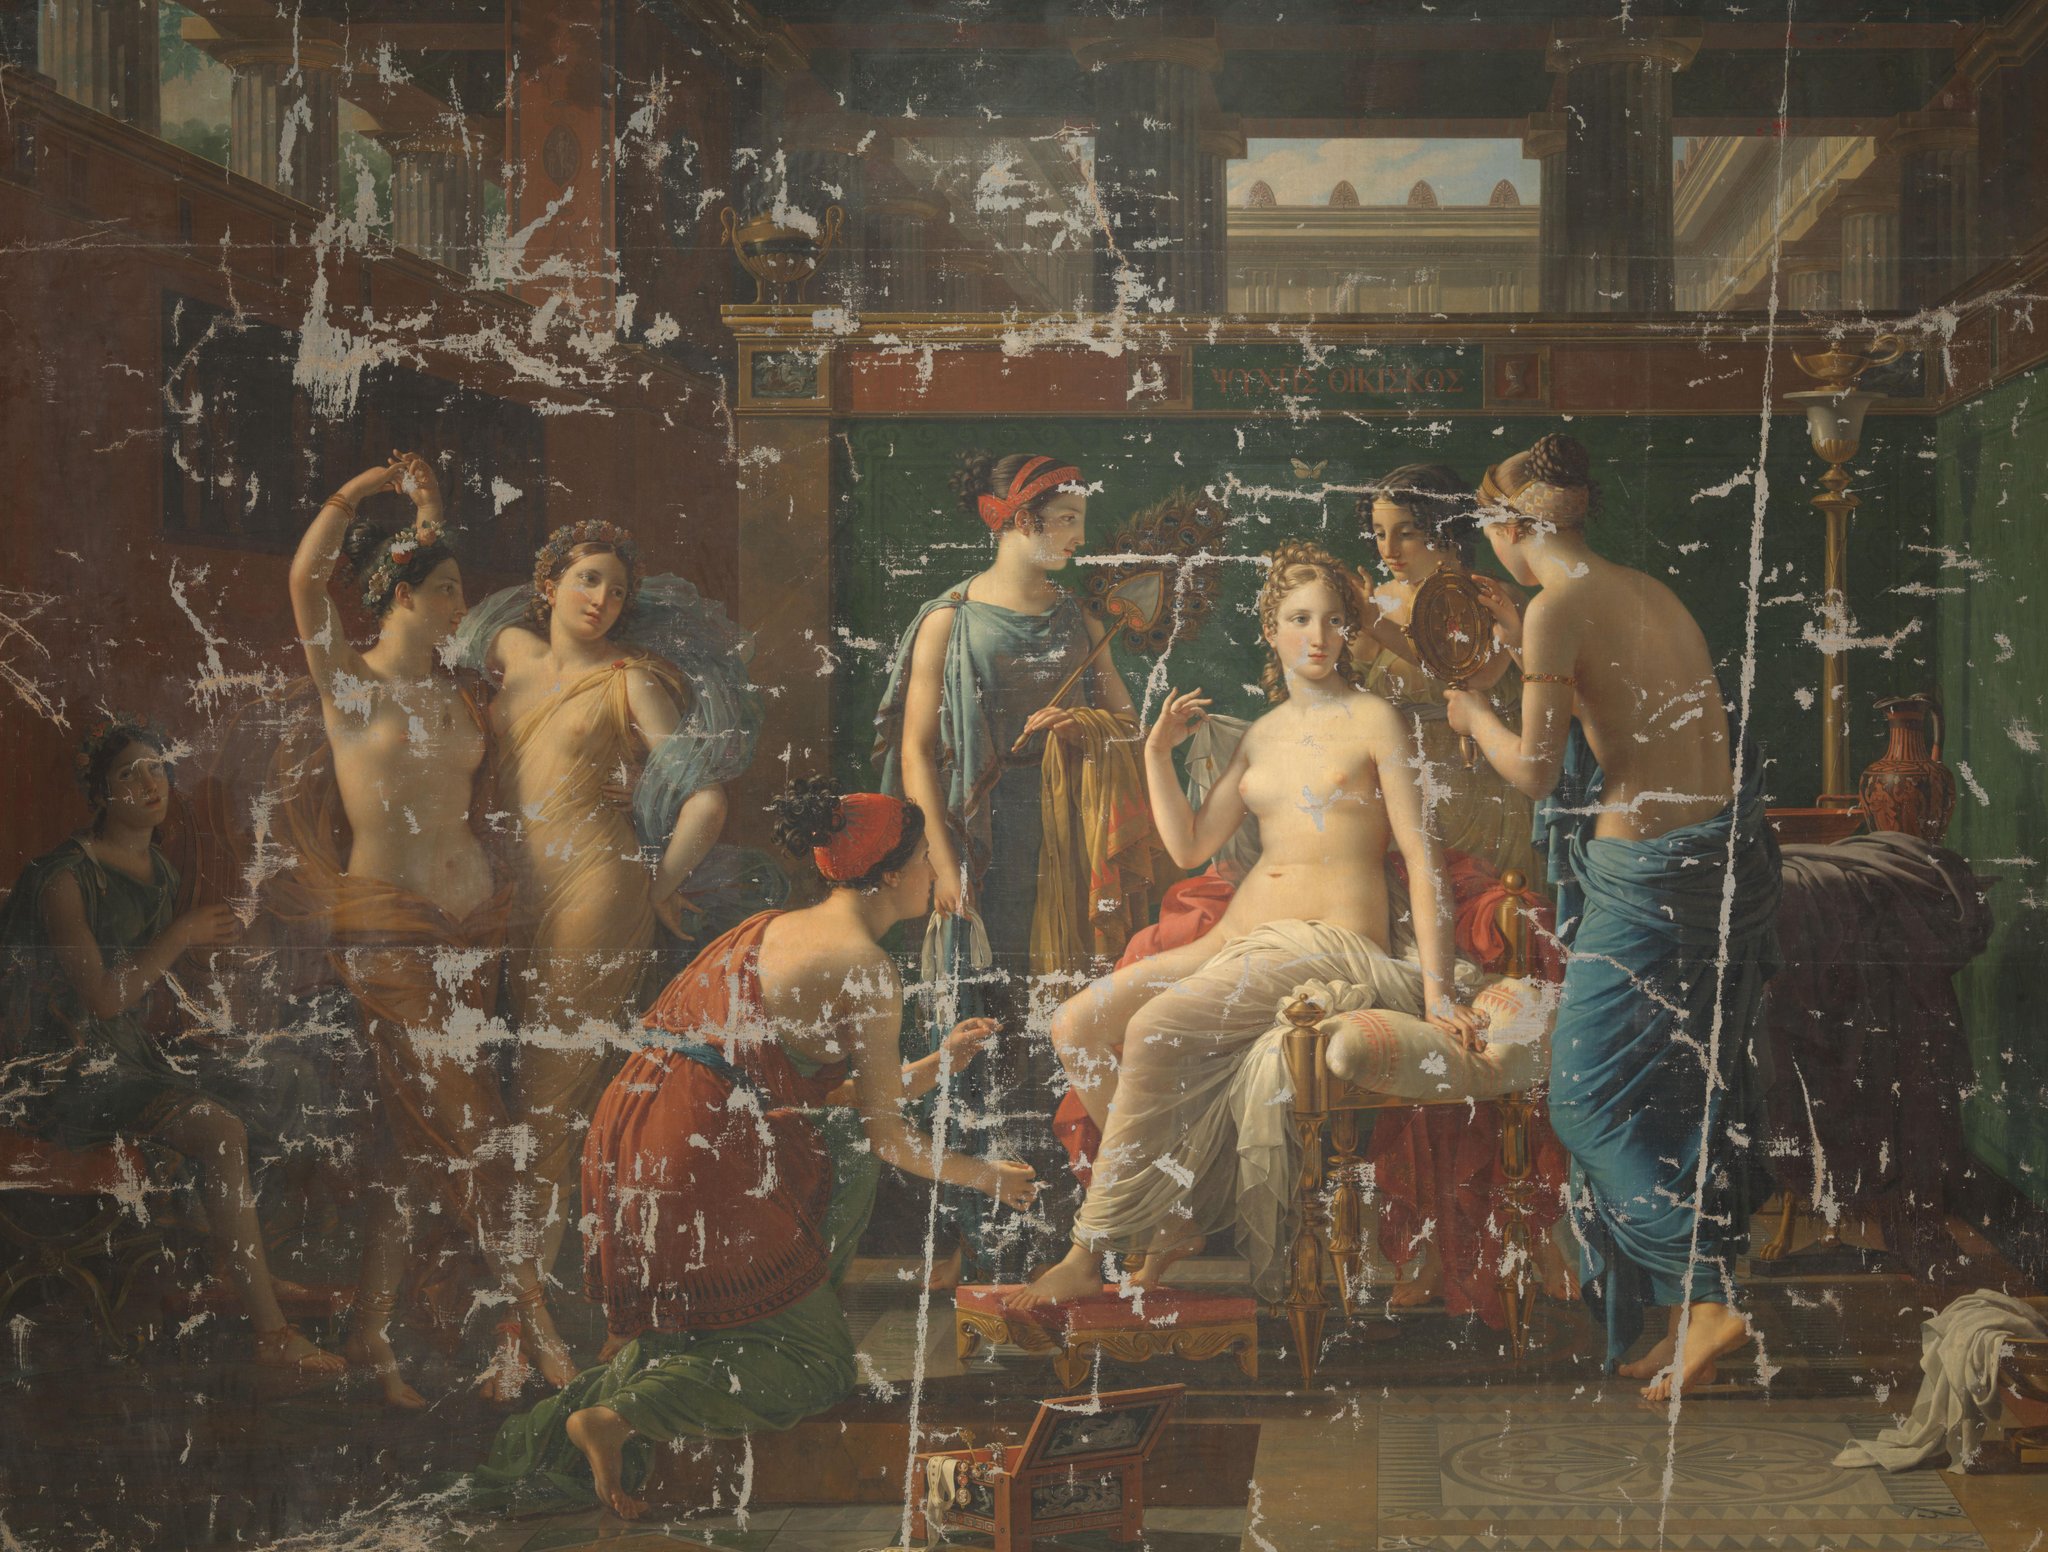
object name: painting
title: The Toilet of Psyche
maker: joseph paelinck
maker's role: painter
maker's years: 1781-1839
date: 1823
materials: canvas, oil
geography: brussels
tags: psyche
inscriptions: signature and date: ‘J. Paelinck 1823’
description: Het toilet van Psyche. Interieur van een paleis waarin Psyche naakt zittend op een stoel haar toilet maakt, omringd door geklede en halfnaakte dienaressen. Een vrouw houdt de maagd een spiegel voor terwijl een ander haar haar verzorgt.